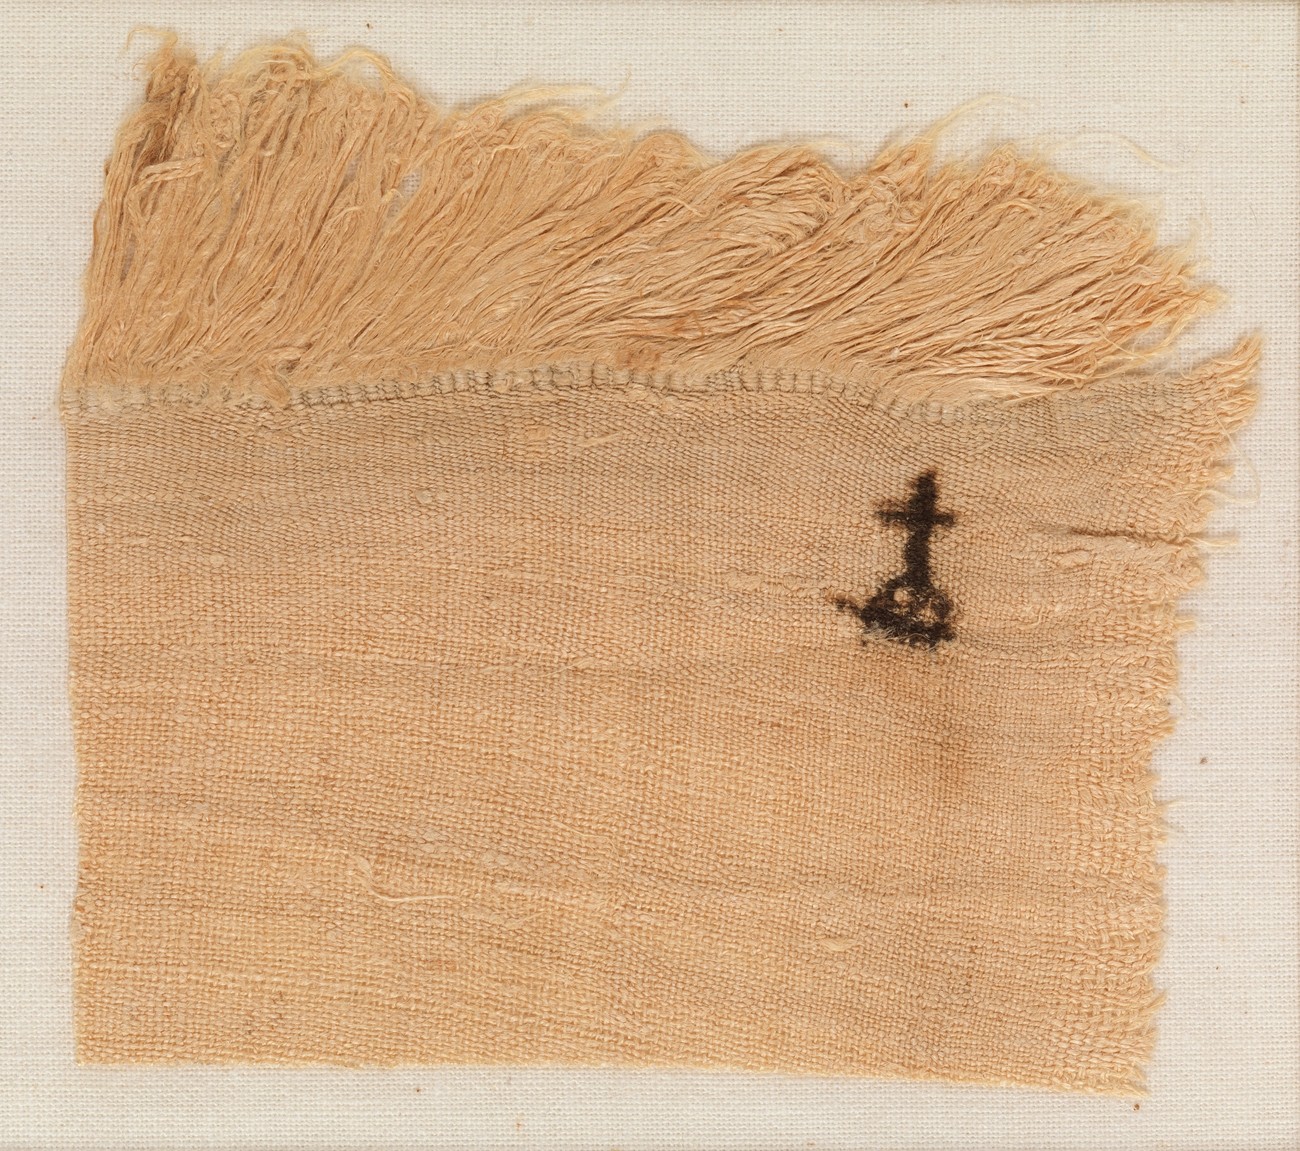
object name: linen mark, wah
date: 1981-1975 BCE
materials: linen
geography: egypt